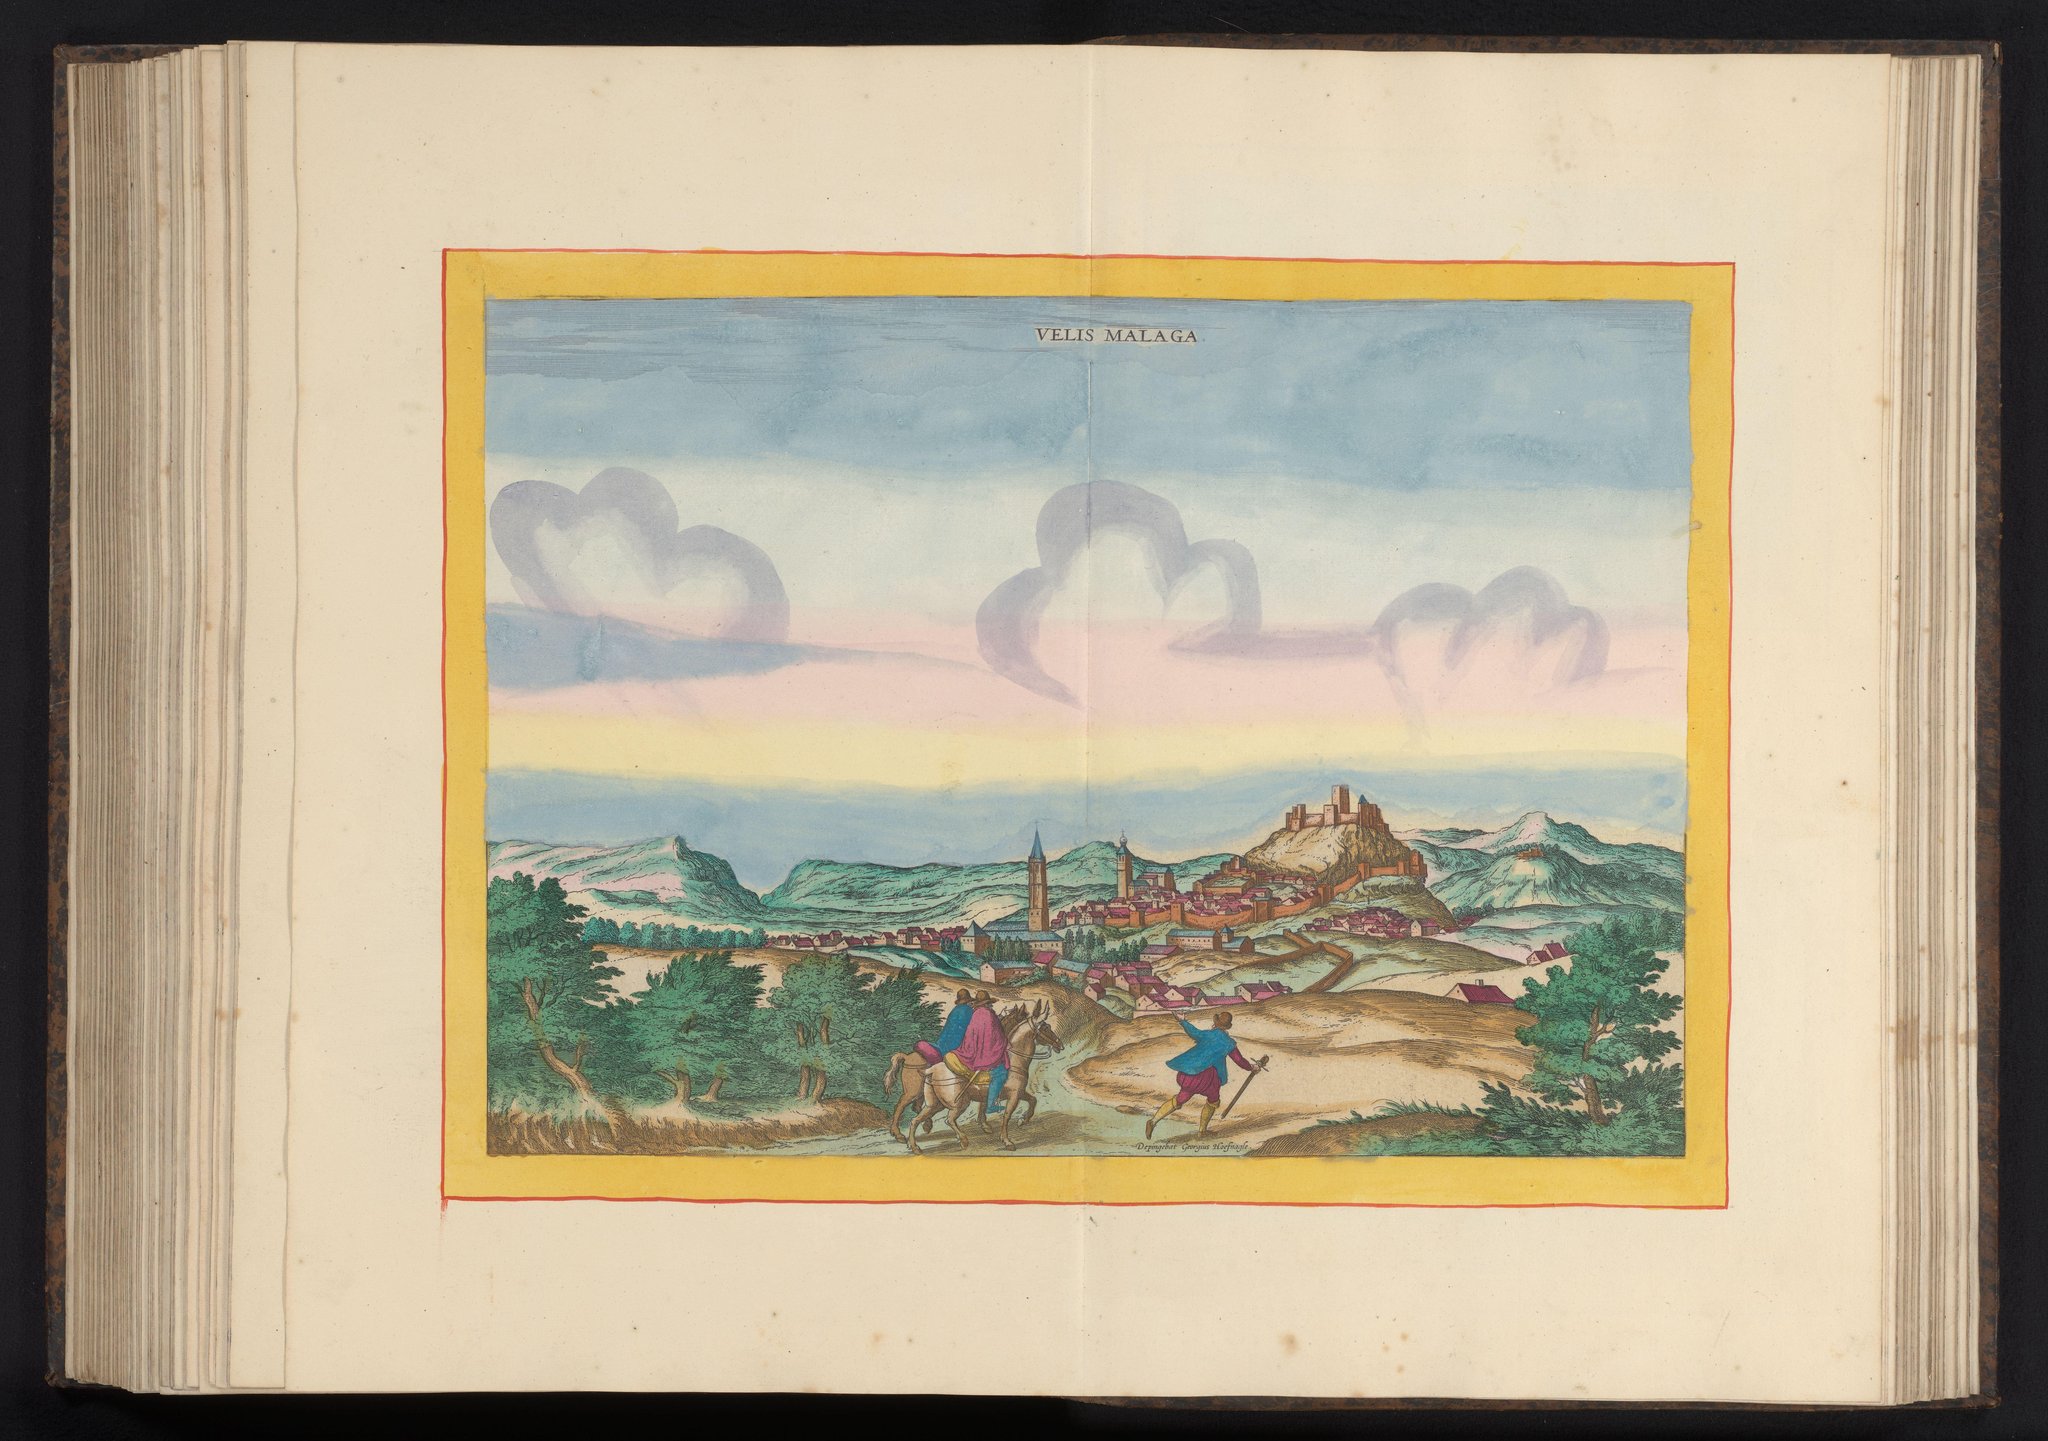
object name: print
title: Gezicht op de plaats Vélez-Málaga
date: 1575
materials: paper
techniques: engraving, etching, hand coloring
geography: vélez-málaga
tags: riding a horse, ass, or mule; rider, horseman, prospect of village, silhouette of village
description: Prent origineel vervaardigd als boekillustratie voor: Georg Braun en Frans Hogenberg. Civitates Orbis Terrarum, 6 delen. Keulen: 1572-1617. De prent werd voor het eerst gepubliceerd in deel 2: De praecipuis totius universi urbibus liber secundus, 1575.